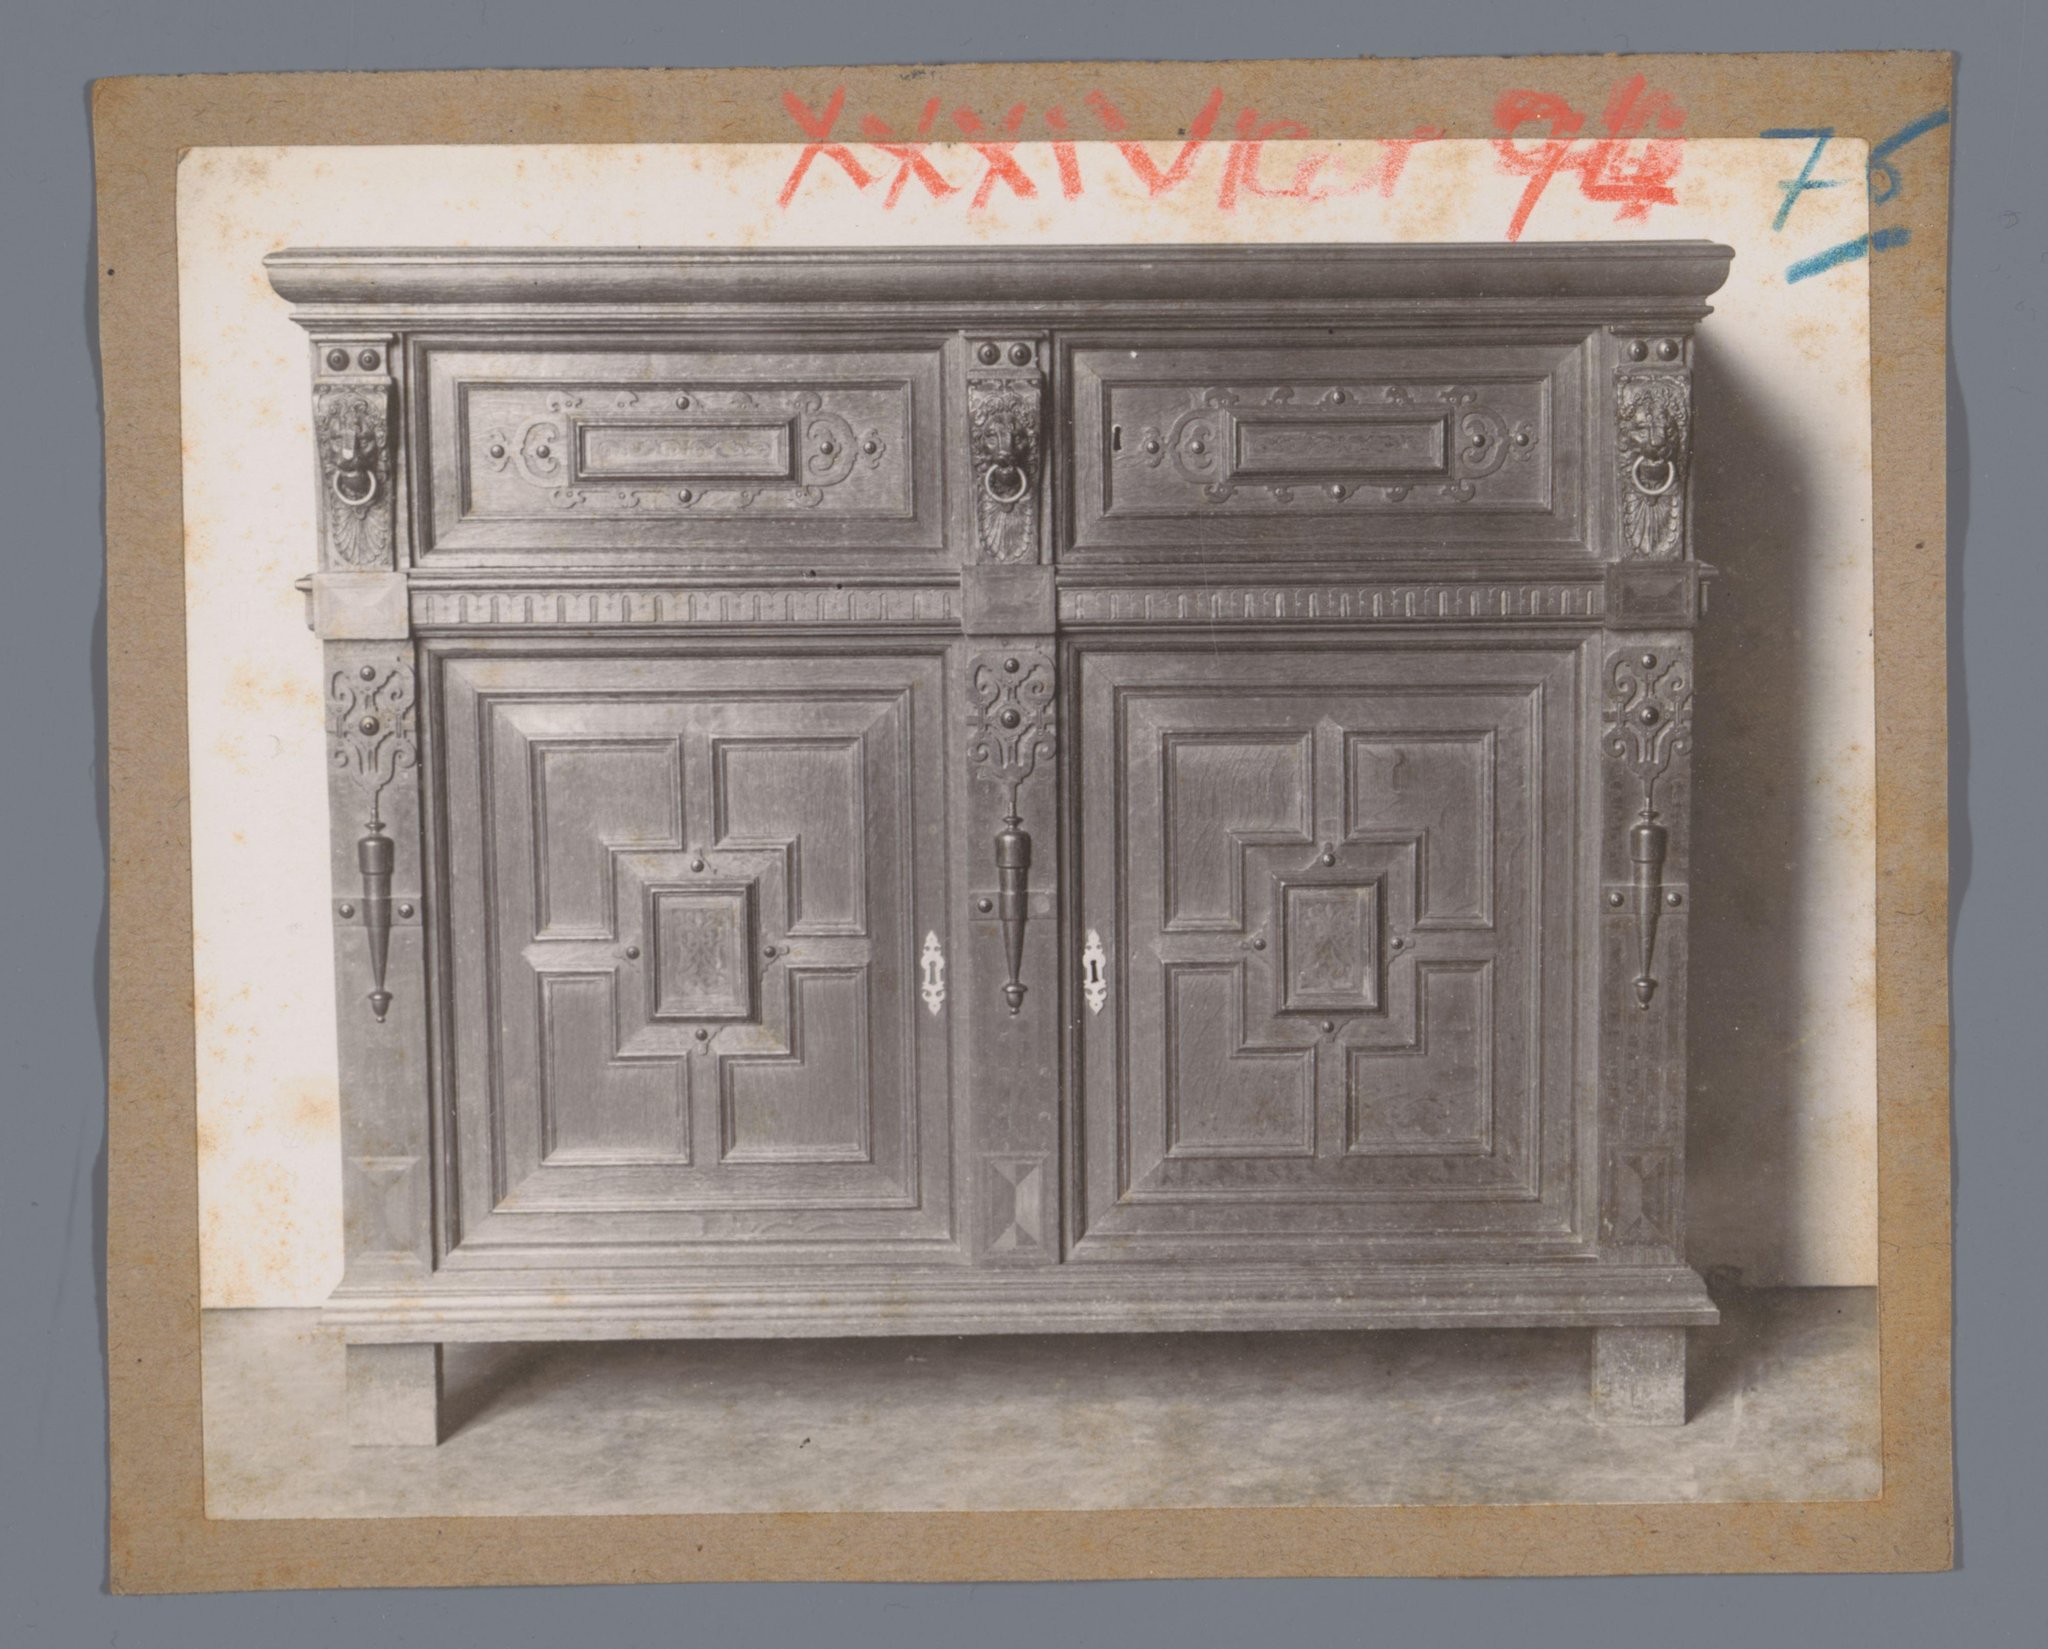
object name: photograph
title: Kast gedecoreerd met leeuwenconsoles met ringen (vermoedelijk) in het Rijksmuseum te Amsterdam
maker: Anonymous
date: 1875-1900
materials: photographic support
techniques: matte daylight collodion silver print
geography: amsterdam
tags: lion's head ~ ornament, cupboard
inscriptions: collector's mark: ‘Instituut voor kunst-nijverheidsonderwijs Gabriël Metsustraat No. 16, Amsterdam’, collector's mark: ‘Kunstnijverheidschool Quellinus Amsterdam Frans Halsstraat 14.’, number: ‘XXXIV kat 94 75’